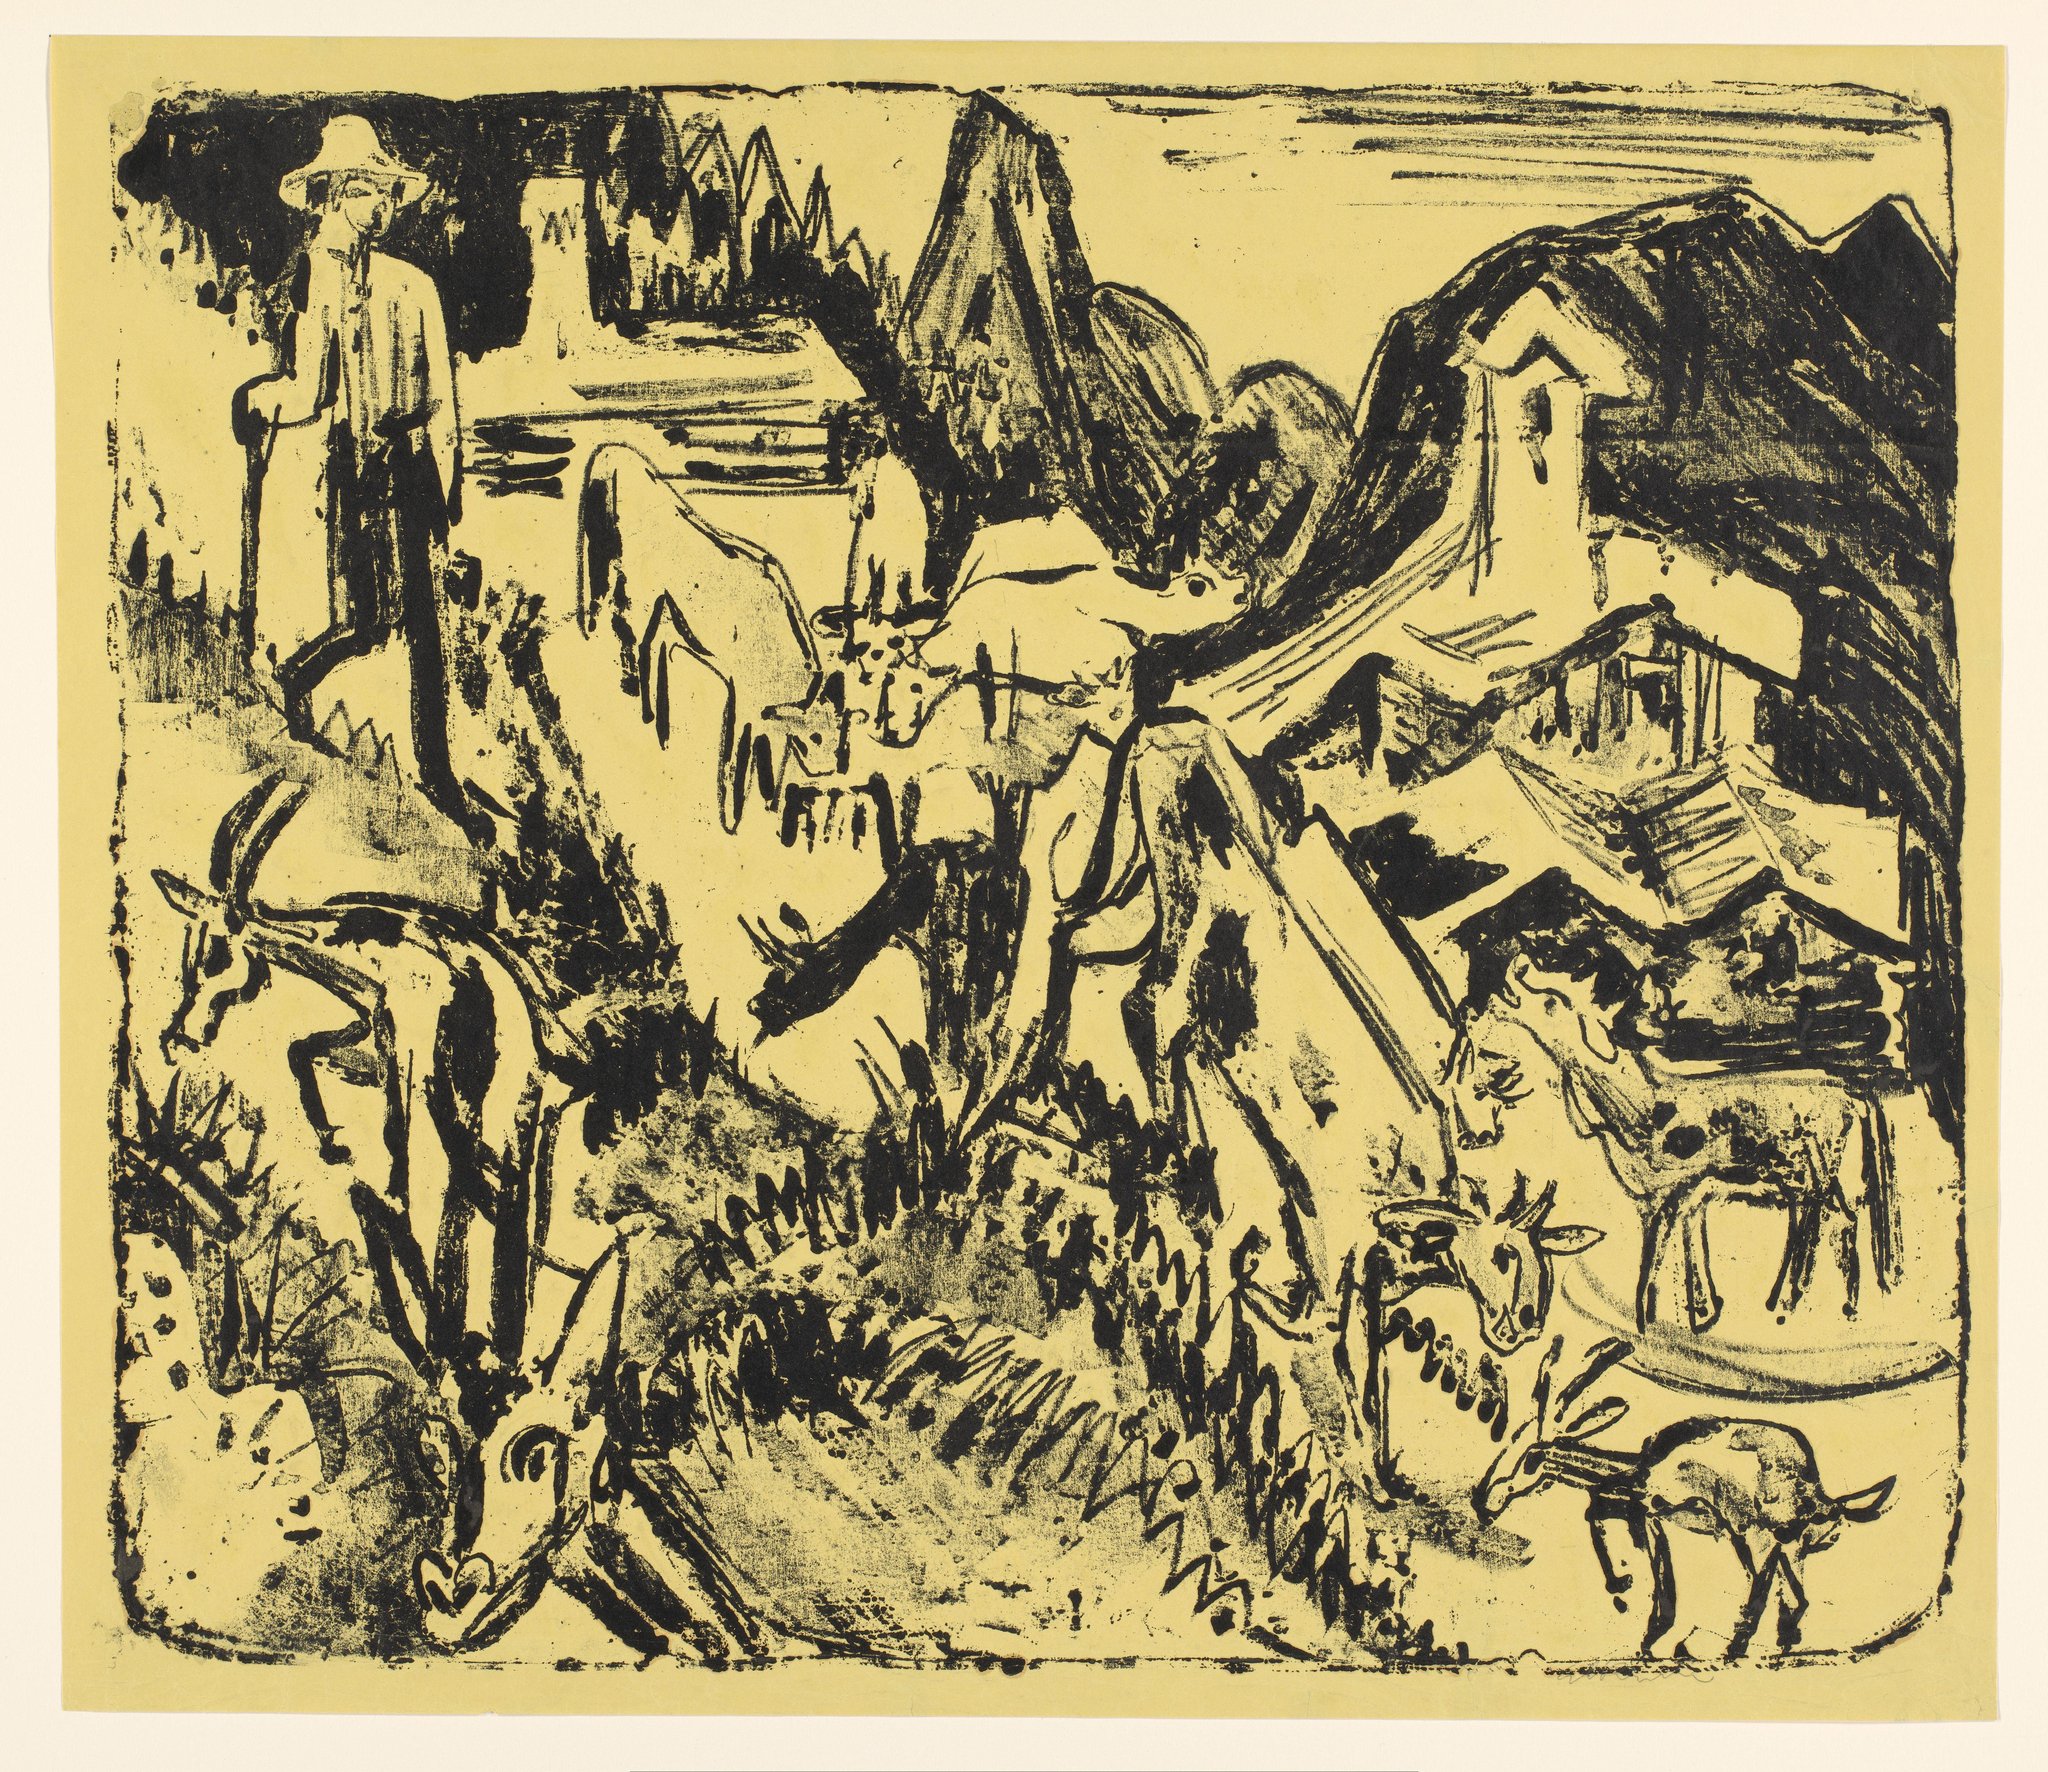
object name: print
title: Geitenhoeder met zijn kudde in de bergen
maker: ernst ludwig kirchner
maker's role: print maker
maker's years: 1880-1938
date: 1890-1938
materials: paper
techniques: lithograph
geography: germany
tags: herding, herdsman, herdswoman, shepherd, shepherdess, cowherd, etc., goat, mountains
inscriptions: collector's mark: Lugt 2760, collector's mark: Lugt 2228